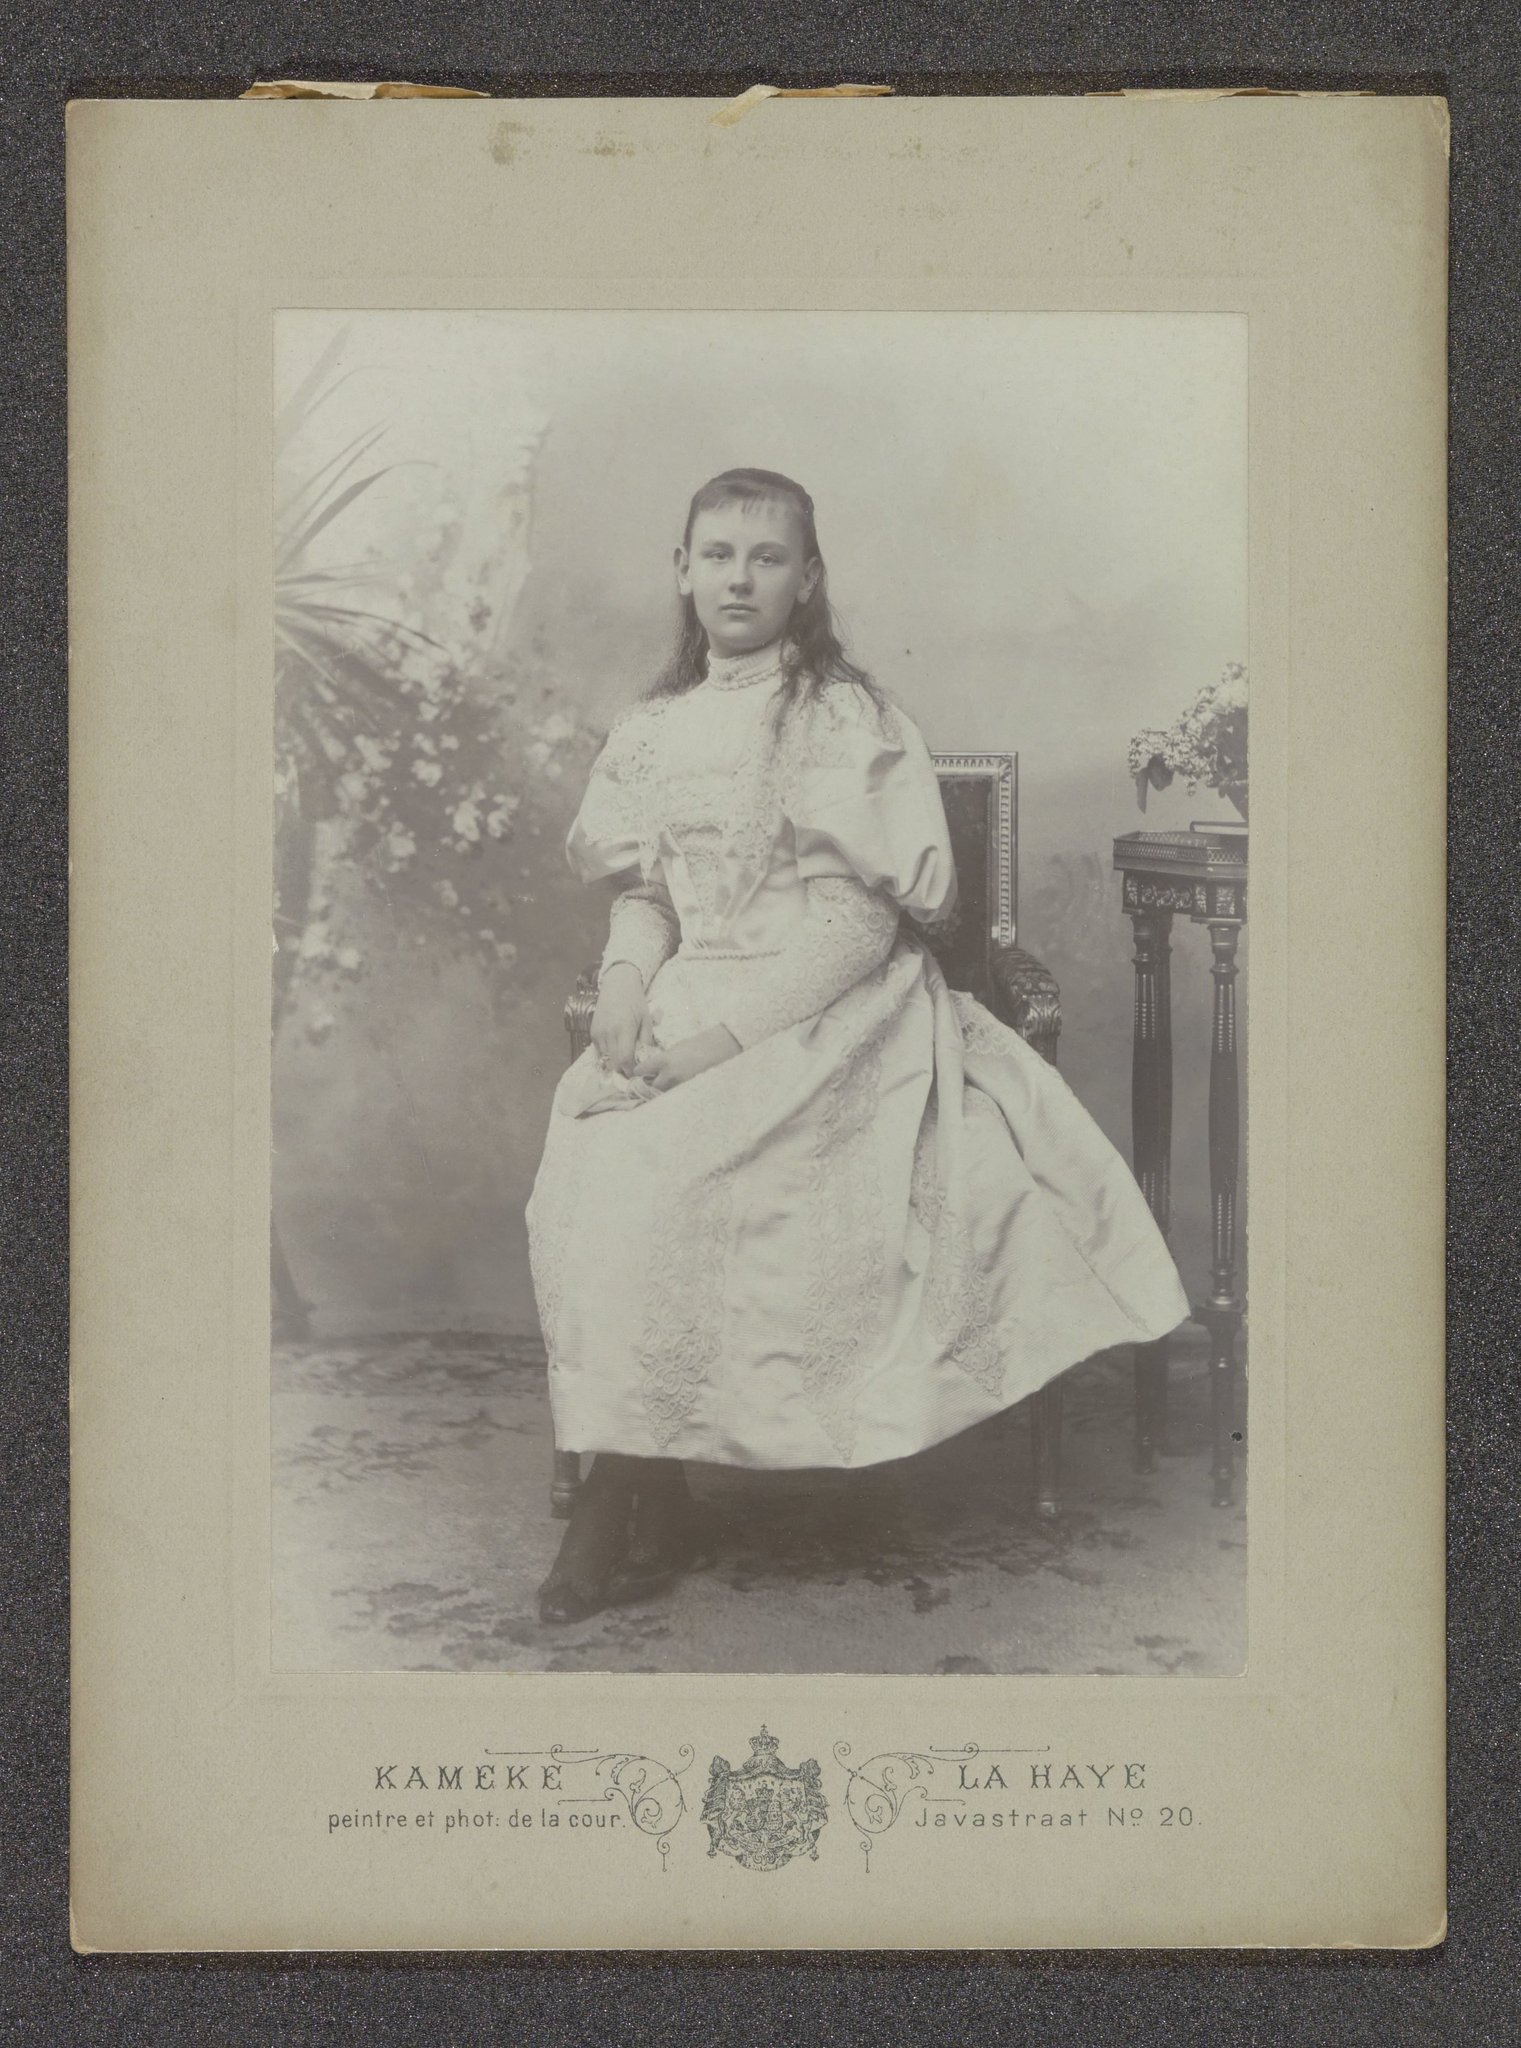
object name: photograph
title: Portret van jeugdige koningin Wilhelmina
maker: kameke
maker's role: painter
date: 1890-1896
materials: photographic support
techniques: albumen print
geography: the hague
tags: wilhelmina of the netherlands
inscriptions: name: ‘Kameke, peintre et phot: de la cour, La Haye Javastraat No 20’